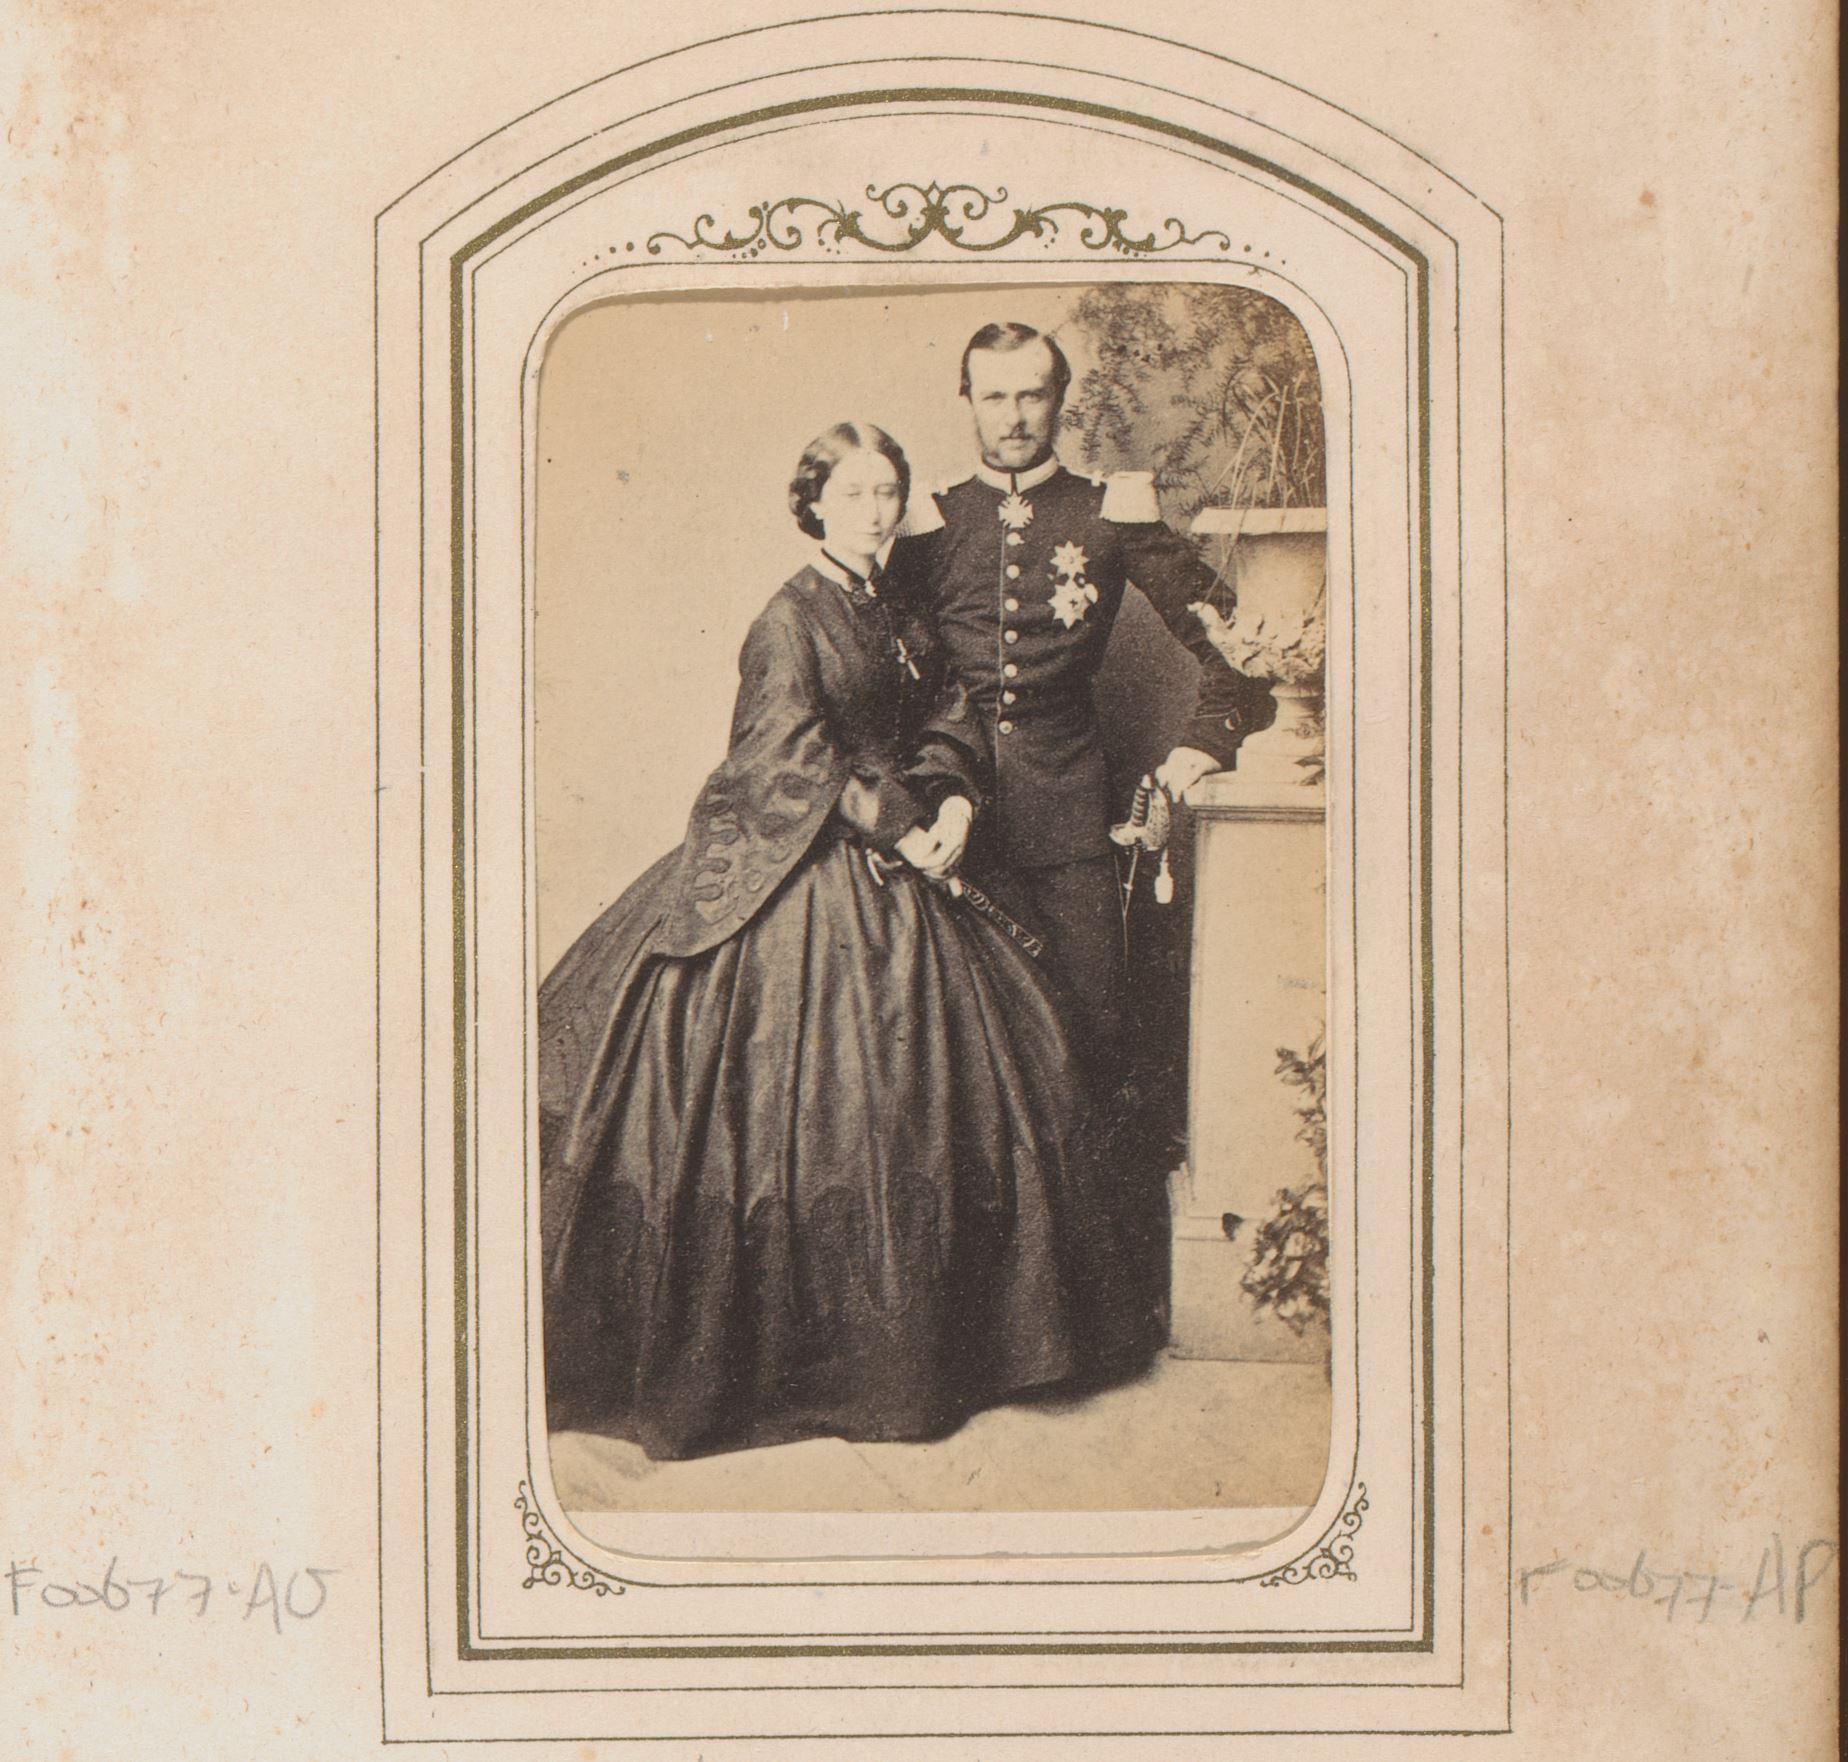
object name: carte de visite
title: Portret van Frederik van Hessen-Kassel en zijn vrouw Maria Anna van Pruisen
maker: Anonymous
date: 1855-1867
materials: cardboard, photographic support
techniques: albumen print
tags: copenhagen (city), berlin, historical persons - bb - woman, historical persons, family of the sovereign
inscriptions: annotation: ‘prins Hessen’, annotation: ‘Prins v. Hessen’